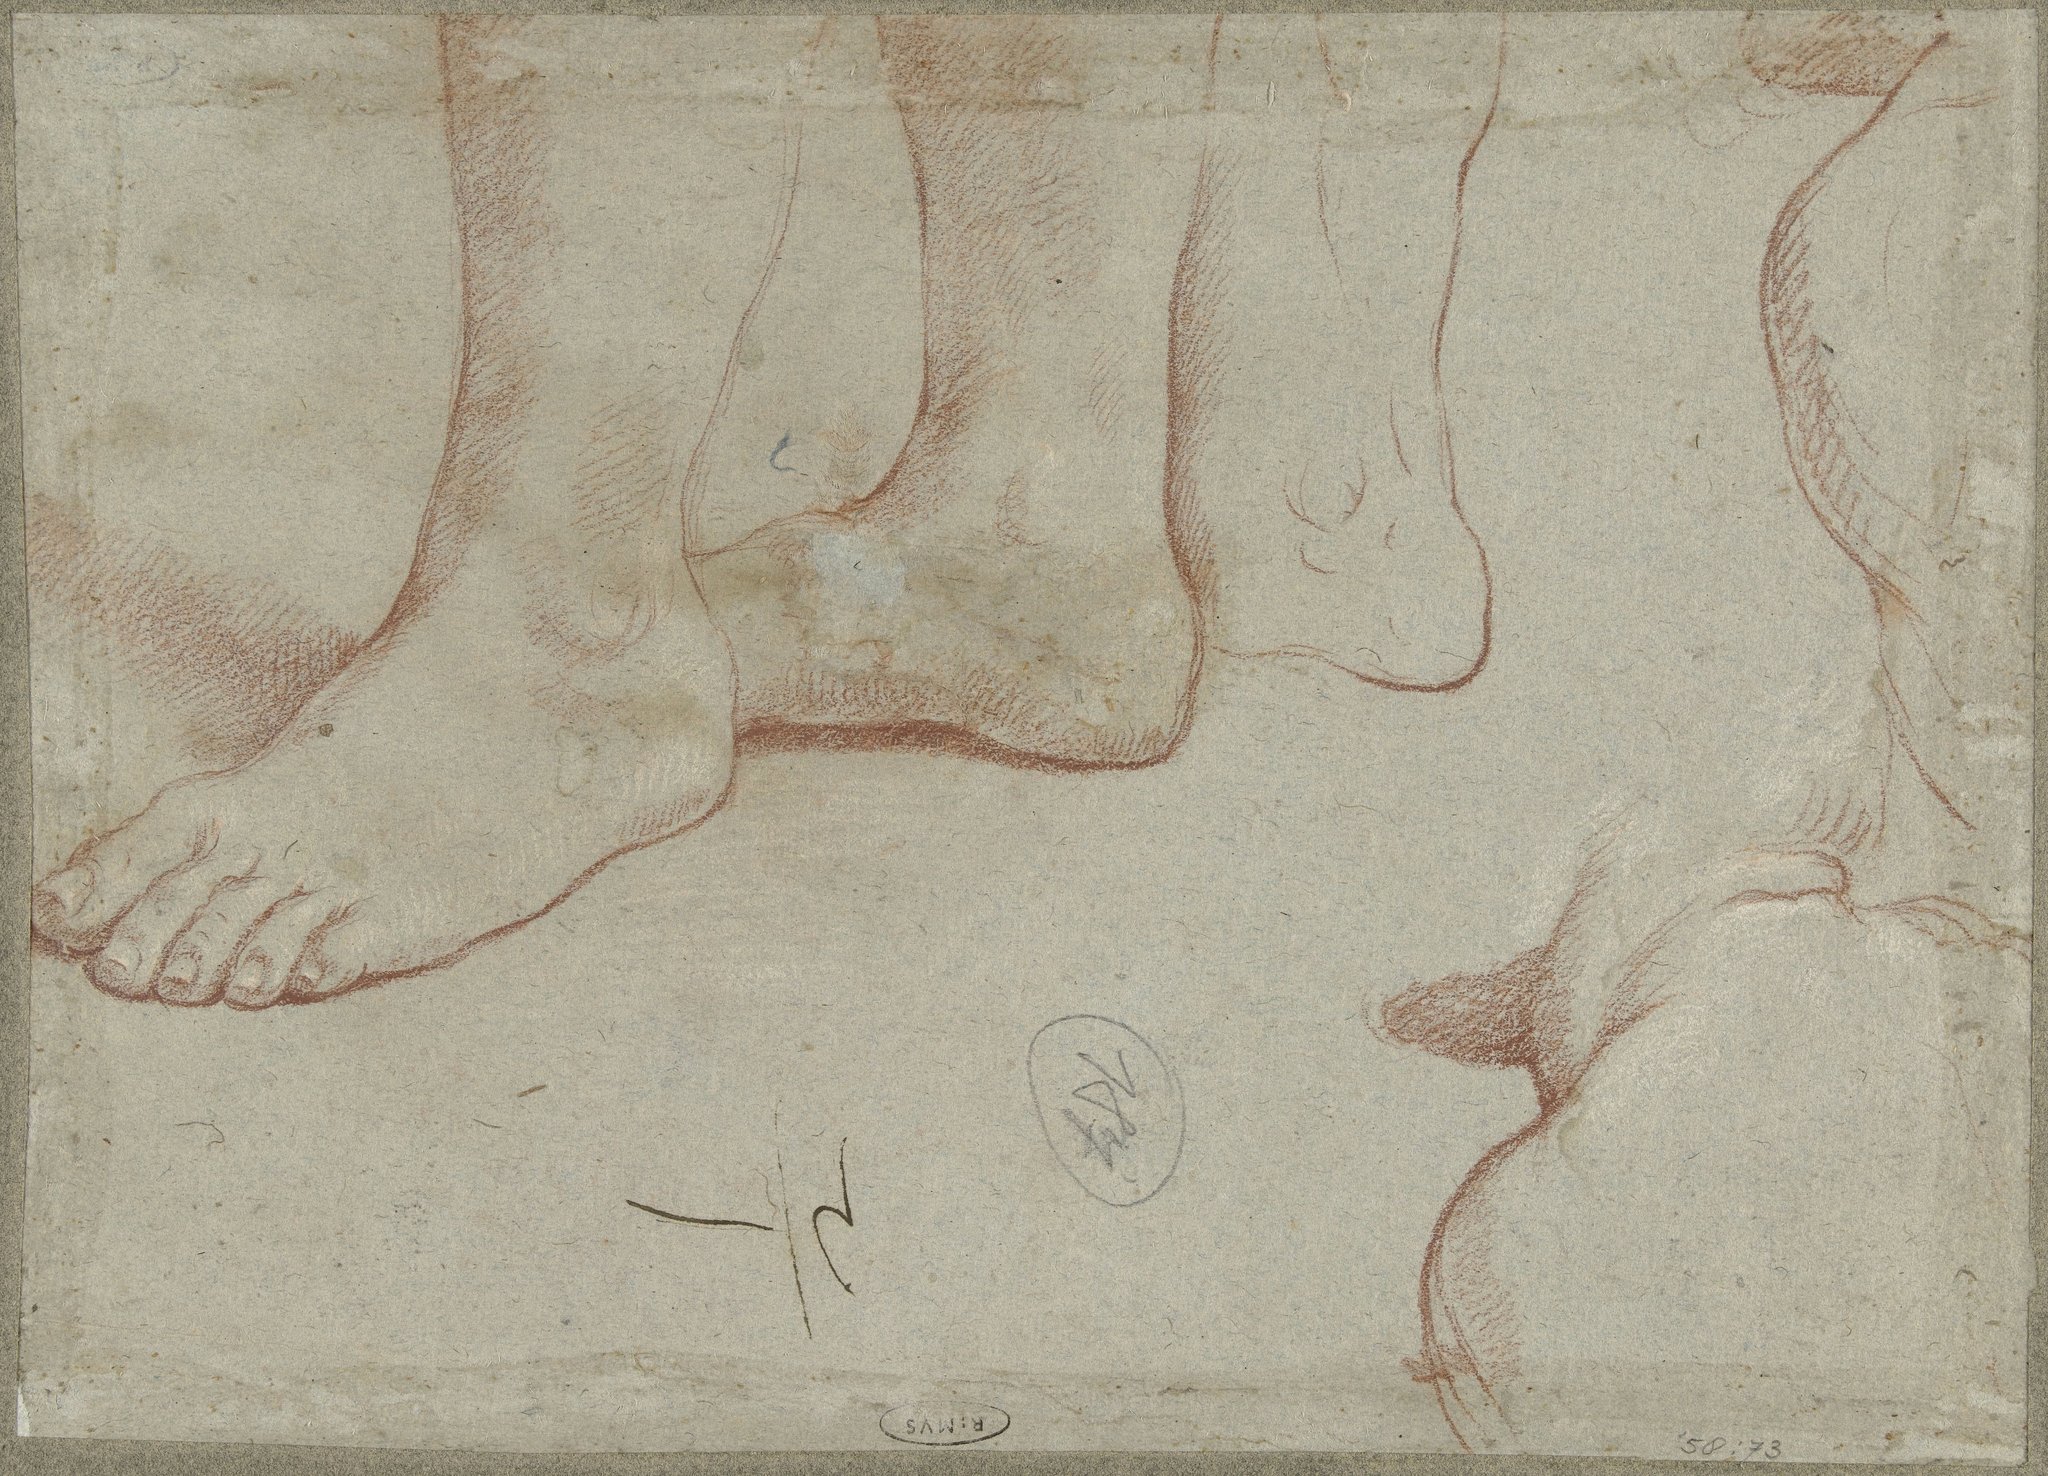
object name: drawing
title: Studies van voeten, hoofd en schouders van een op de rug geziene man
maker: guido reni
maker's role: draughtsman, painter, print maker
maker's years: 1575-1642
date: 1608-1616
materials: chalk, paper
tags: foot